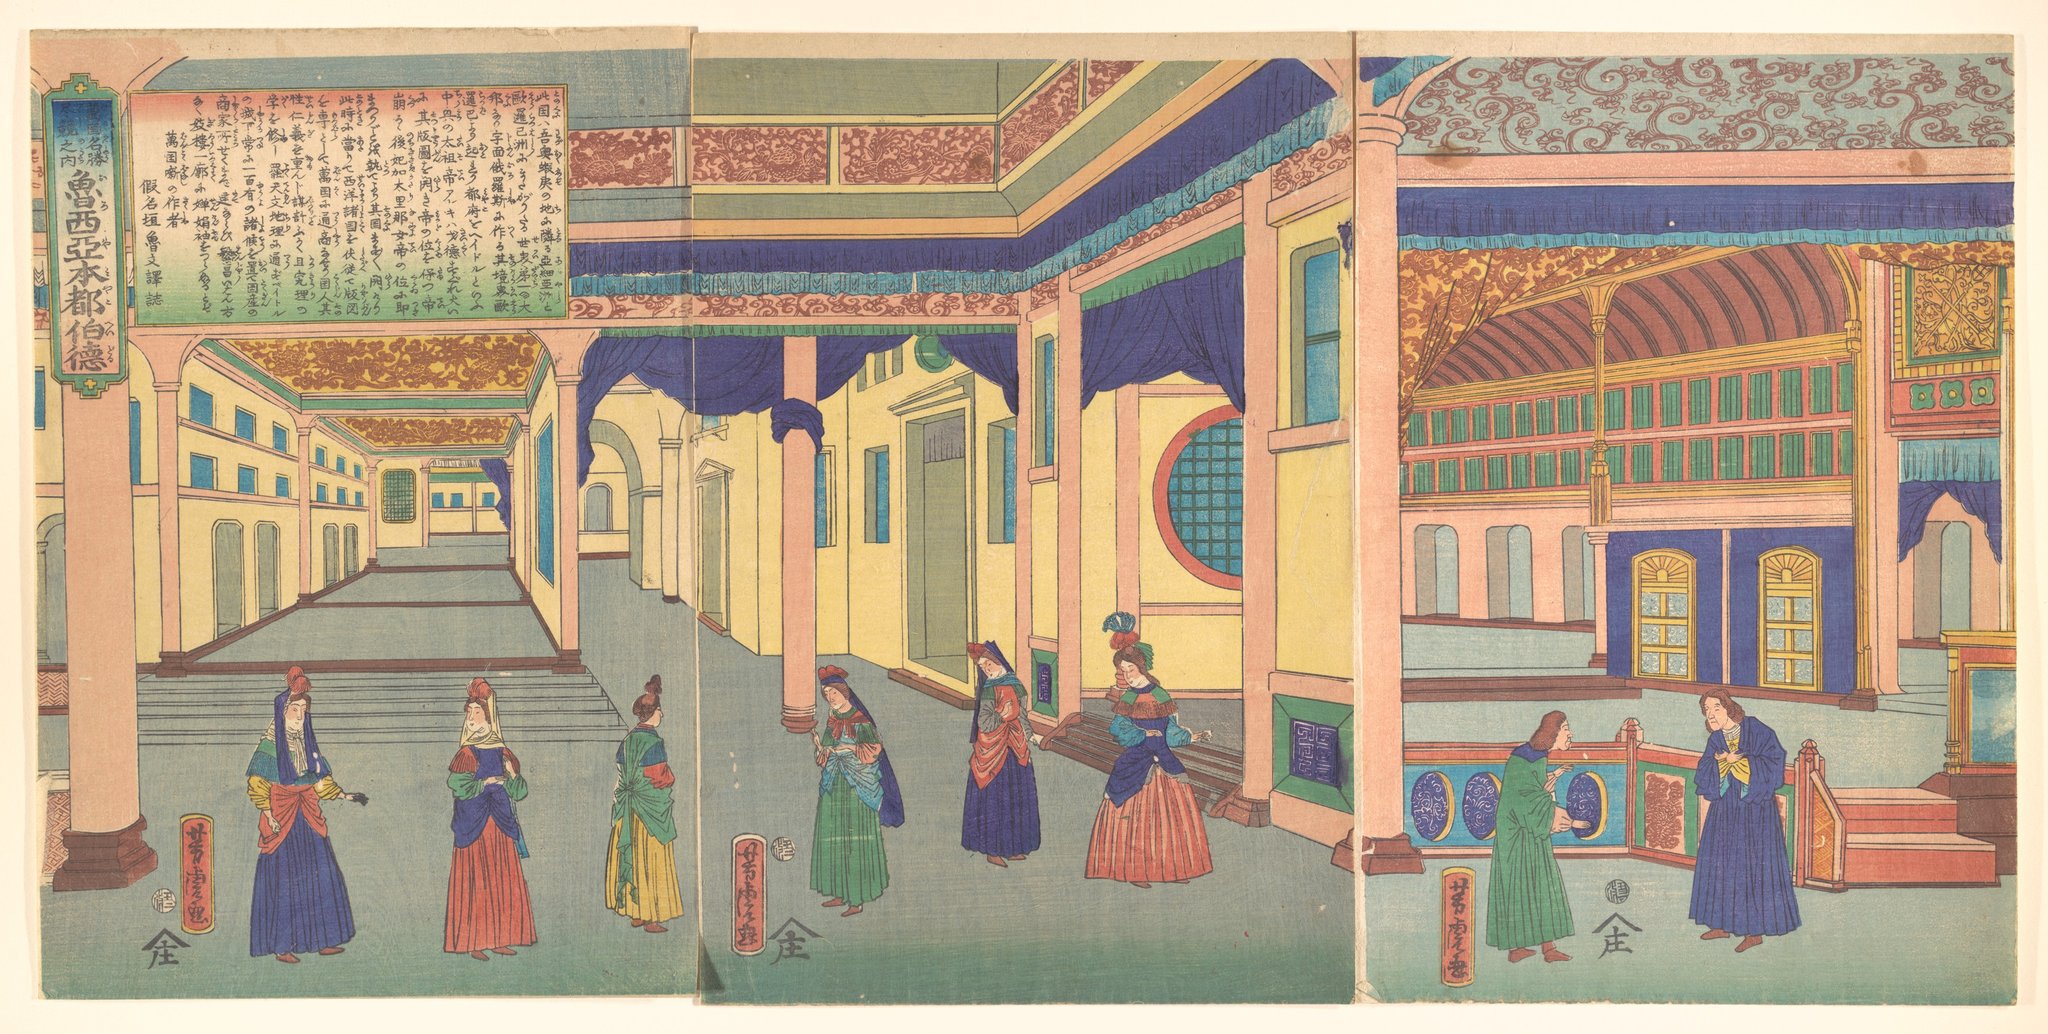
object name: print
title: Heidoru (St. Petersberg), Capital of Russia, from the series Famous Places from All Nations (Bankoku meisho zukushi - Oroshiya miyako heidoru)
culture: japanese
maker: utagawa yoshitora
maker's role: artist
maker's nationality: japanese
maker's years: 1845-1880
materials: ink, paper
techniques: woodblock print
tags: interiors,men,women